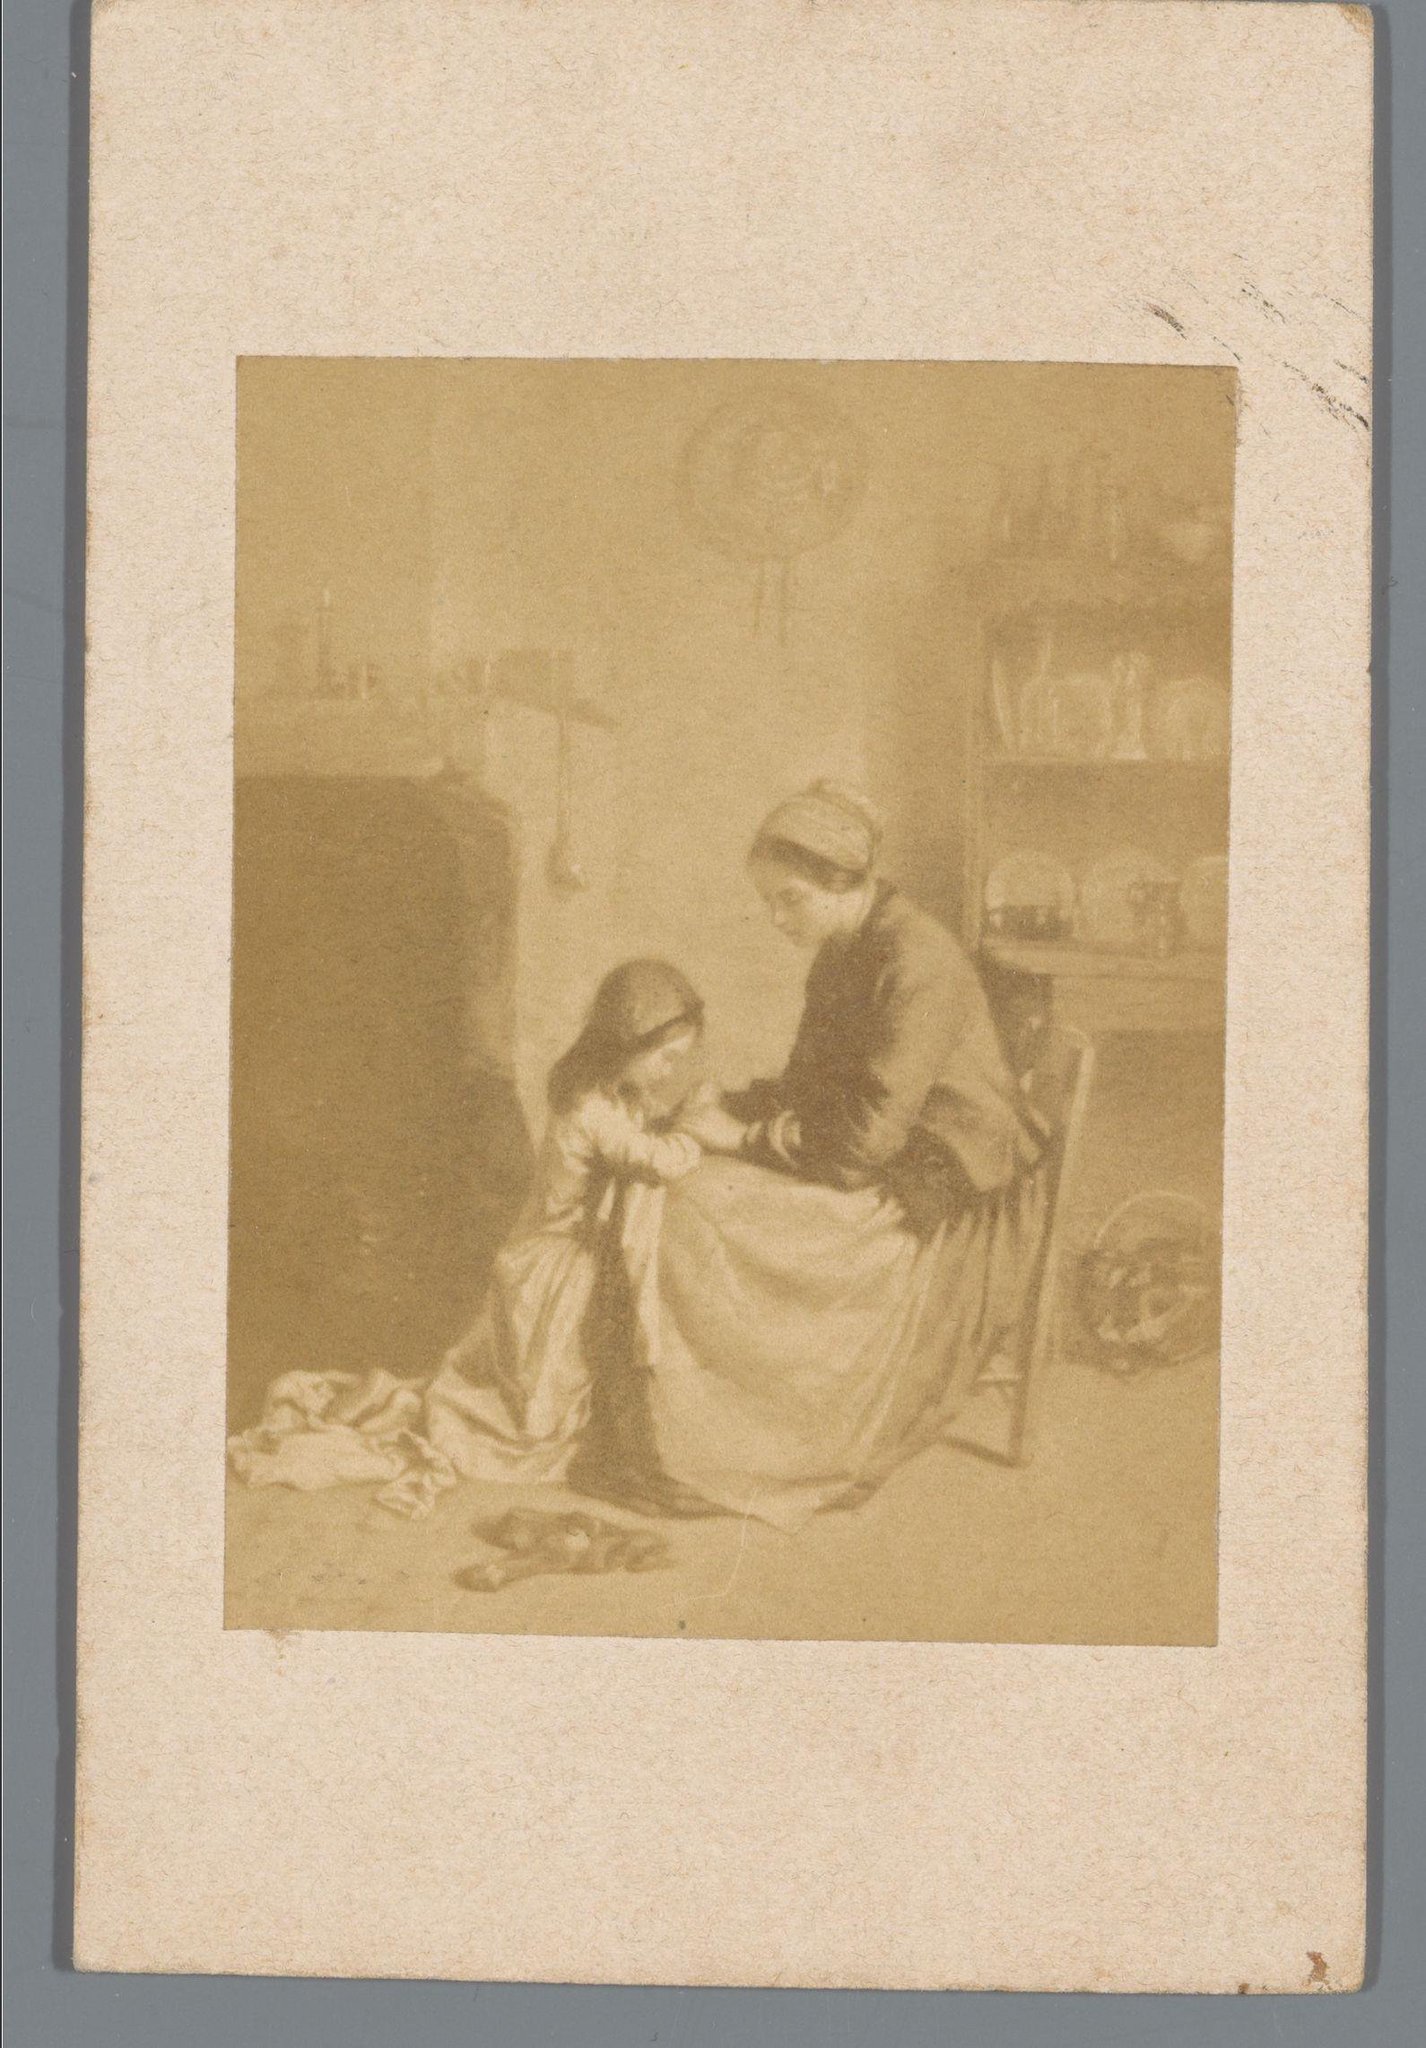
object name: reproduction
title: Fotoreproductie van een schilderij naar het gedicht Avondbede door J.J.L. ten Kate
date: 1850-1900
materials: cardboard, photographic support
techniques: albumen print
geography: amsterdam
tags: mother with son(s) and daughter(s) (mother-love), (private) prayer; 'oratione', 'preghiere', 'preghiere a dio' (ripa)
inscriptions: inscription: ‘AVONDBEDE./ (...) Moeder droomen!/ J. J. L. TEN KATE.’